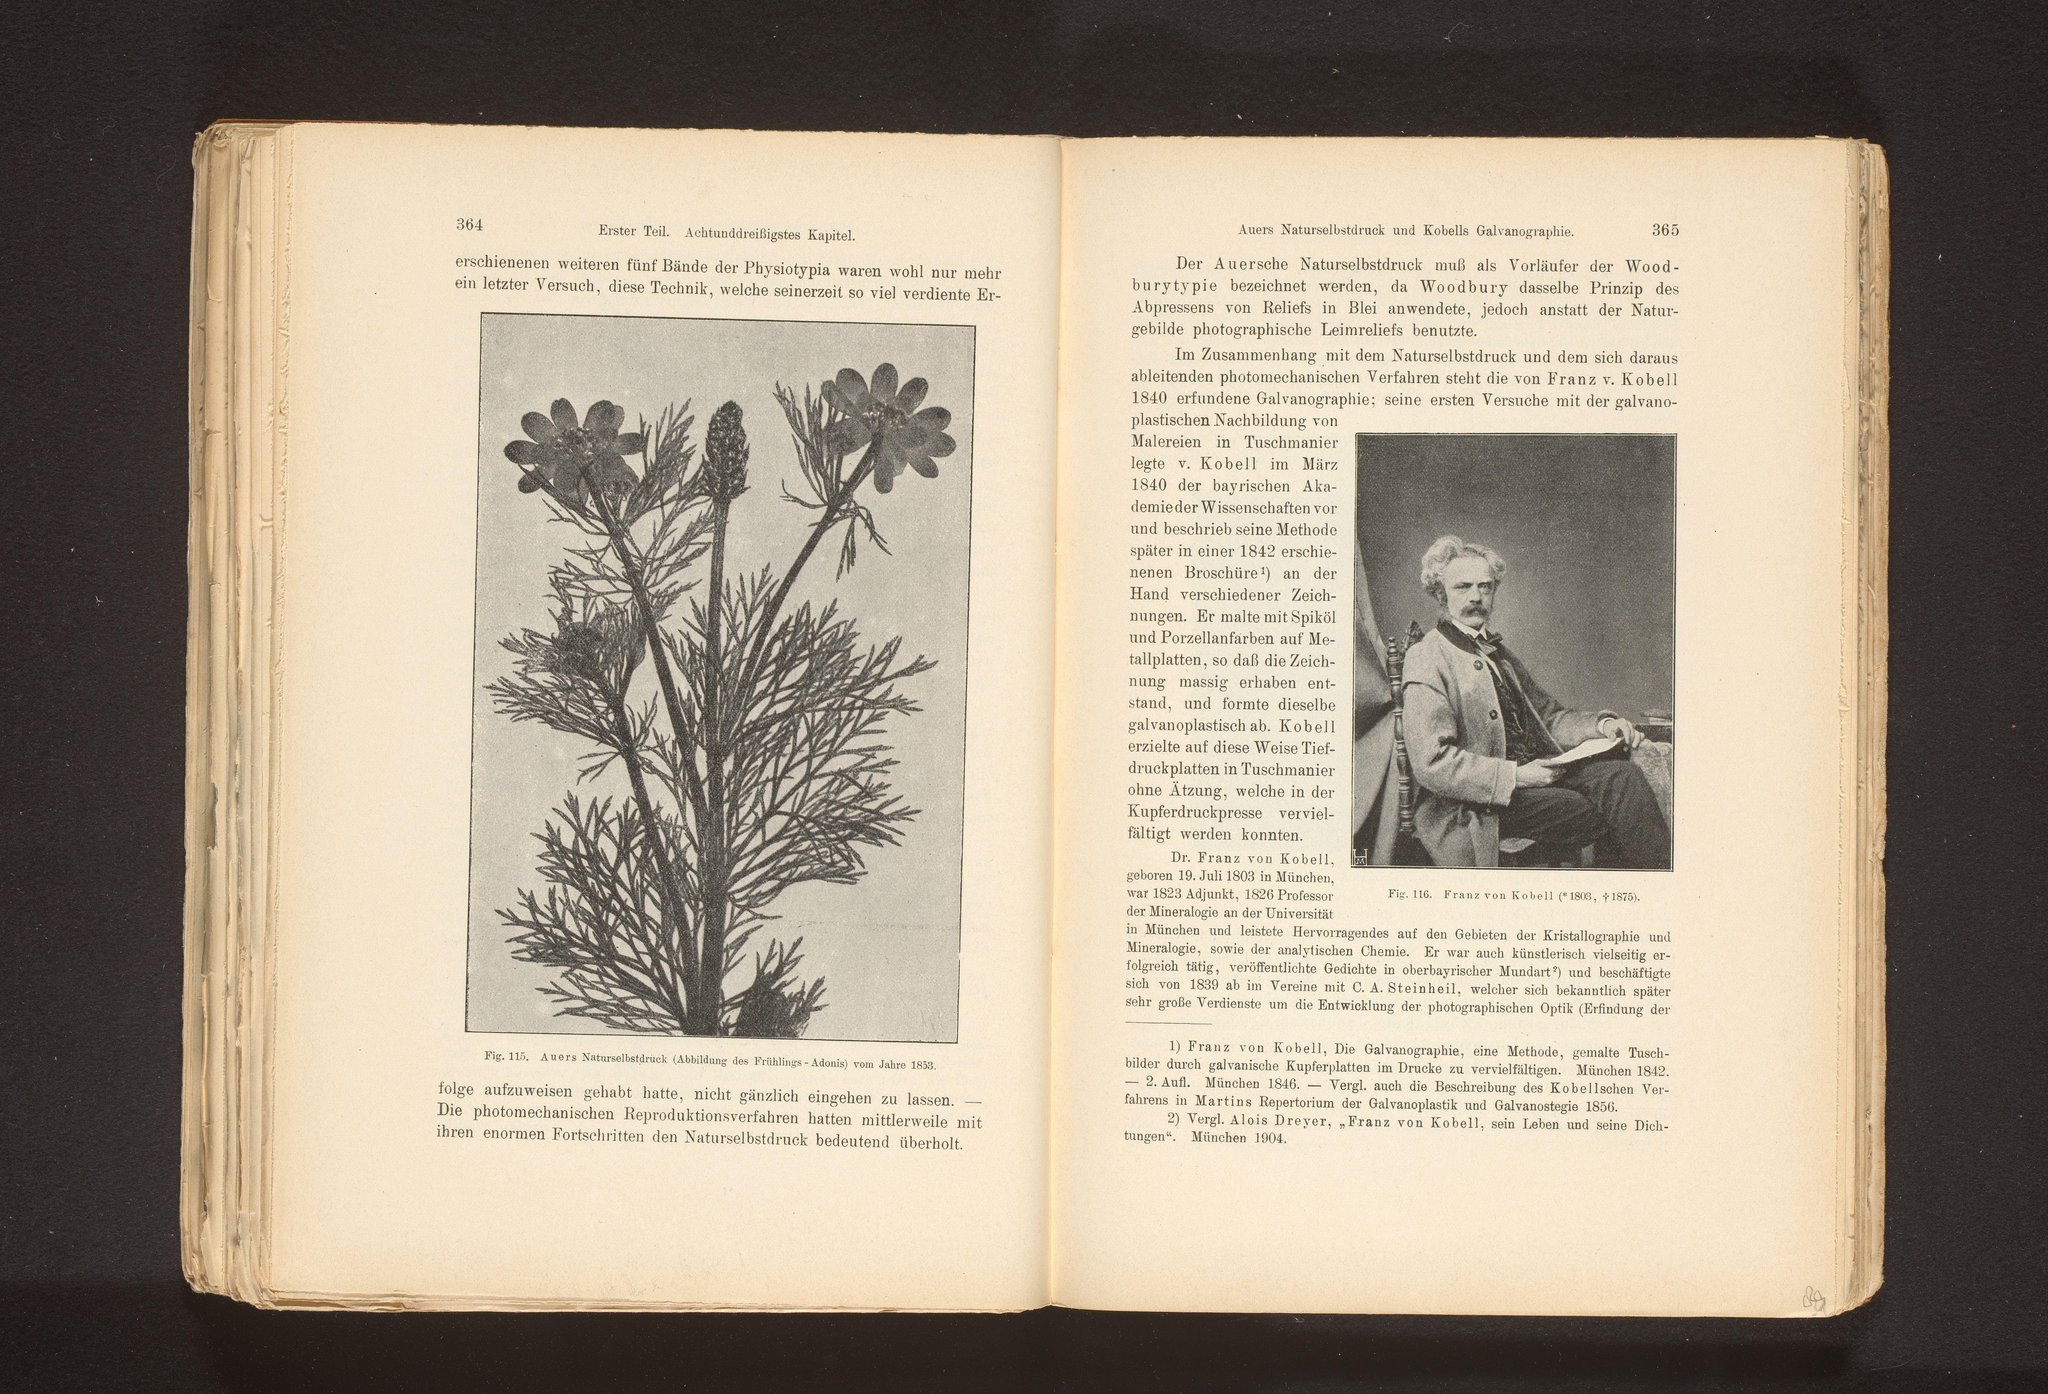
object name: page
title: Voorjaarsadonis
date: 1900-1905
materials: paper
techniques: autotype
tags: flowers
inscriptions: number: ‘Fig. 115.’, inscription: ‘Auers Naturselbstdruck’